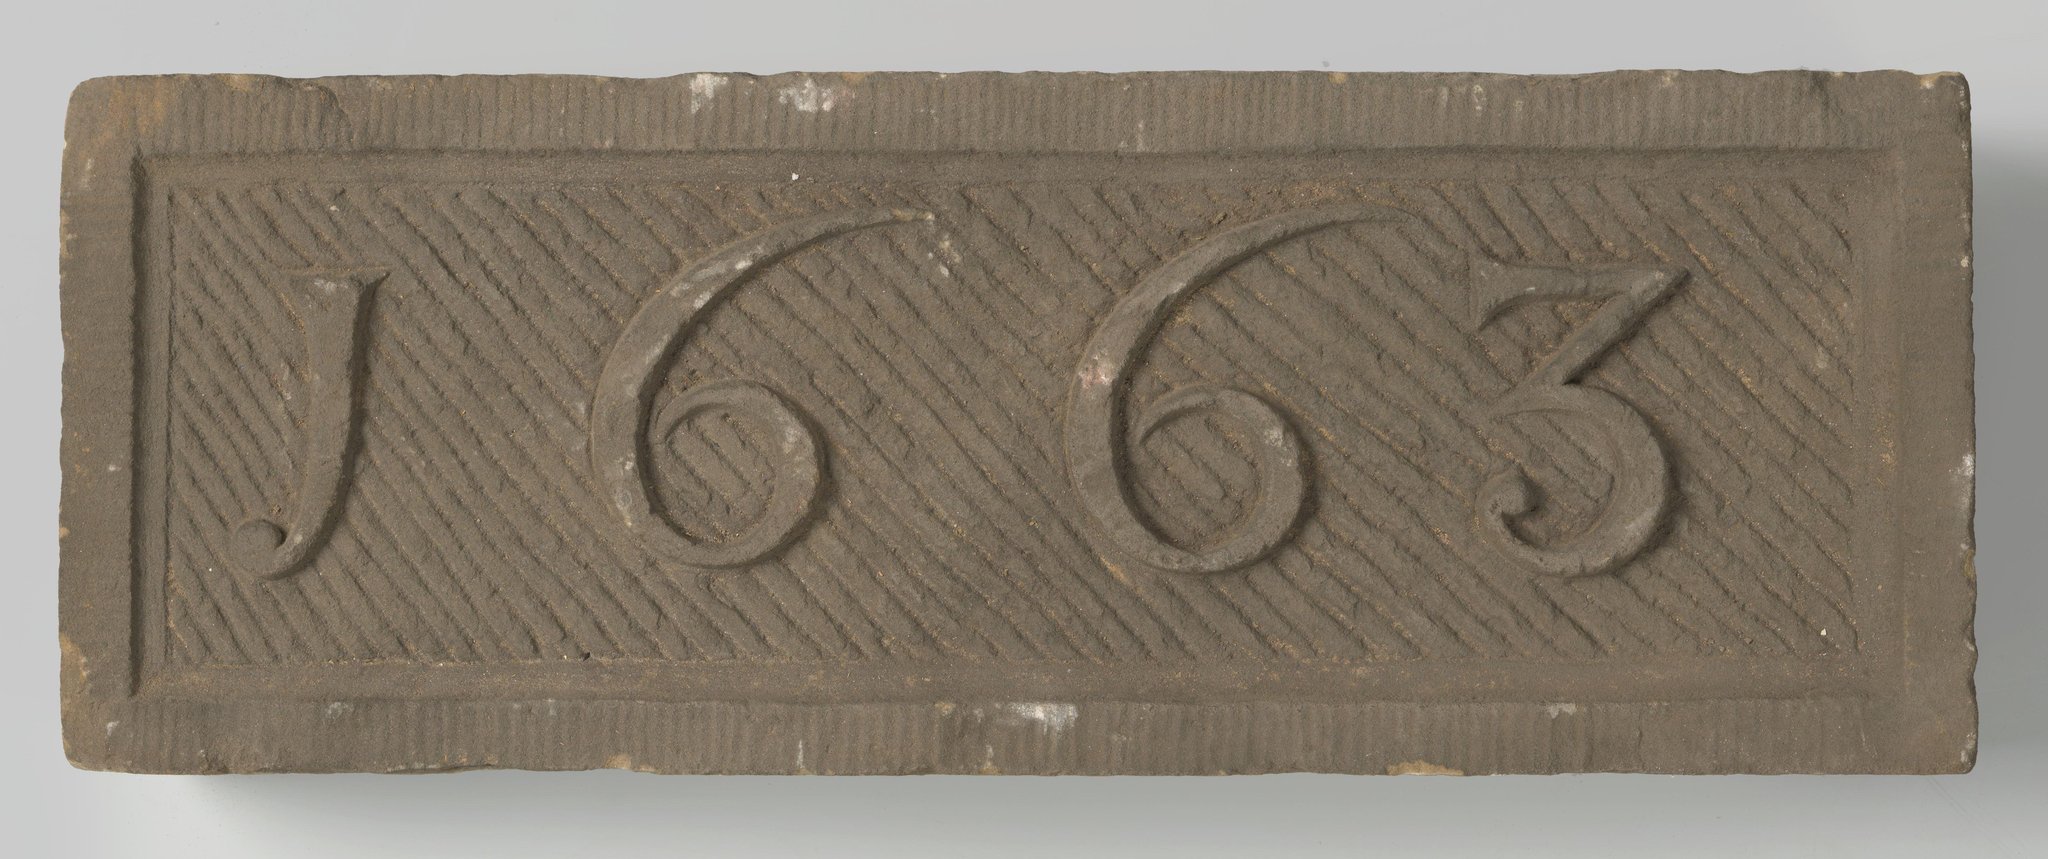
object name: gable stone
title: Gevelsteen met jaartal 1663.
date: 1663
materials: stone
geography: netherlands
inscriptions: date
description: Liggende rechthoek met rondom een gearceerde rand en een gearceerde ondergrond waarop het jaartal 1663. Bij de steen horen twee gevelstenen: KOG-ALS-146-1 met twee spuwende koppen en KOG-ALS-146-2 met ANNO.